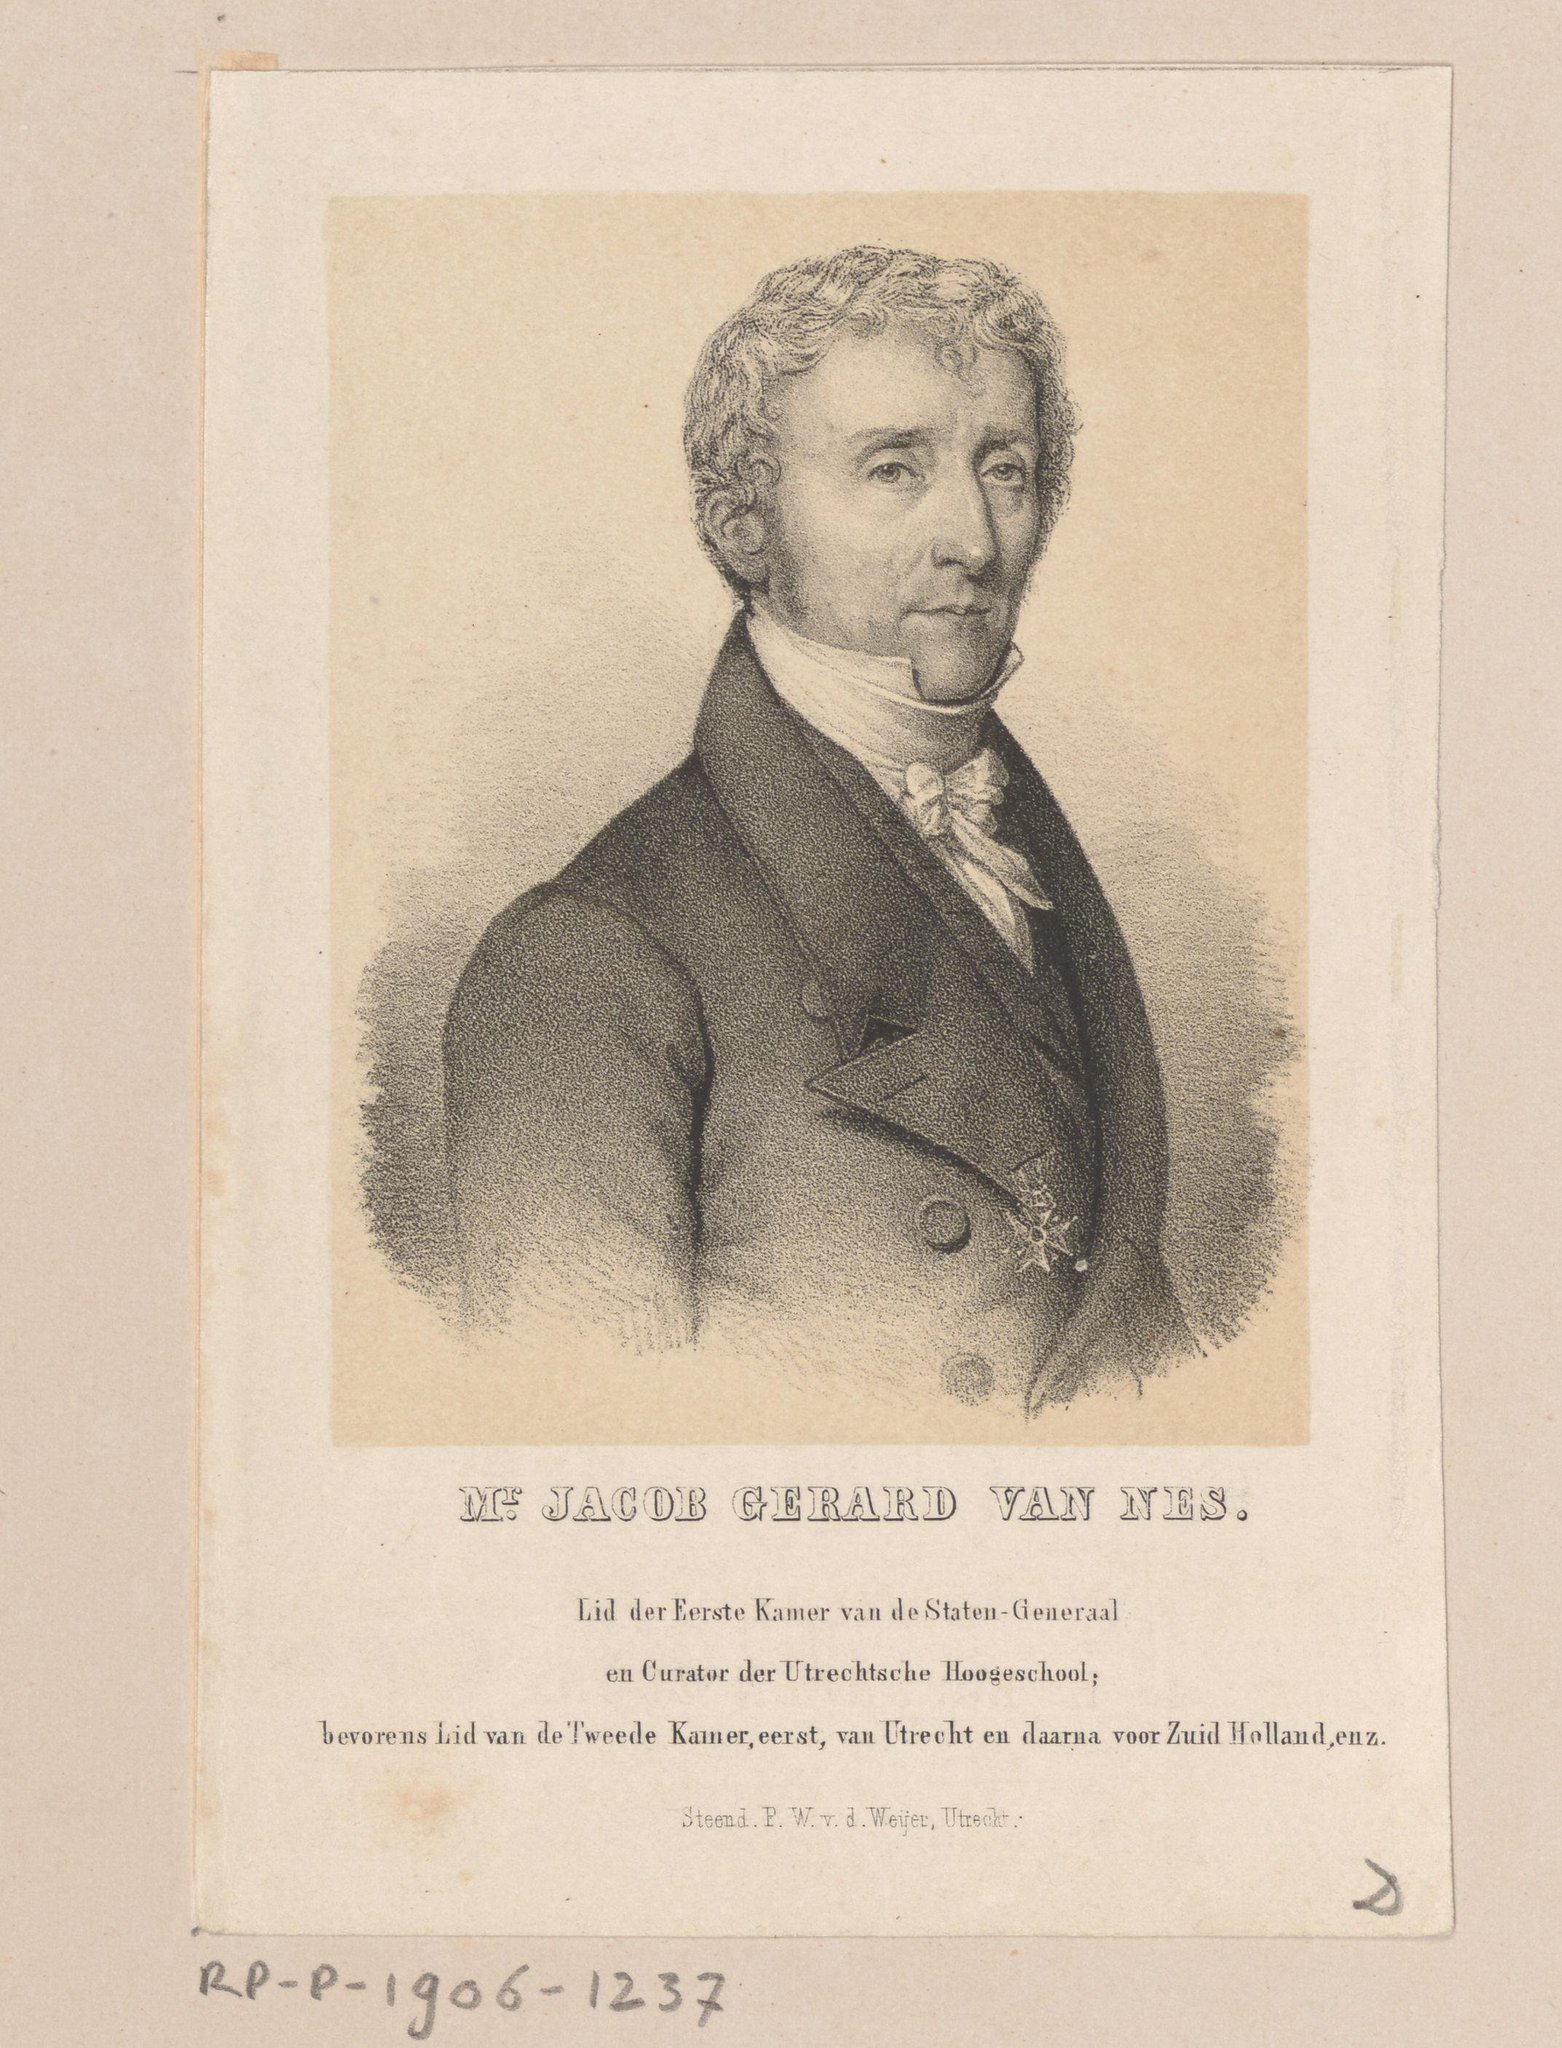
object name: print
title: Portret van Jacob Gerard van Nes van Meerkerk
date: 1844-1880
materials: paper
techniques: tone lithography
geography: utrecht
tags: utrecht, historical persons, national government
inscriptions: collector's mark: Lugt 2228